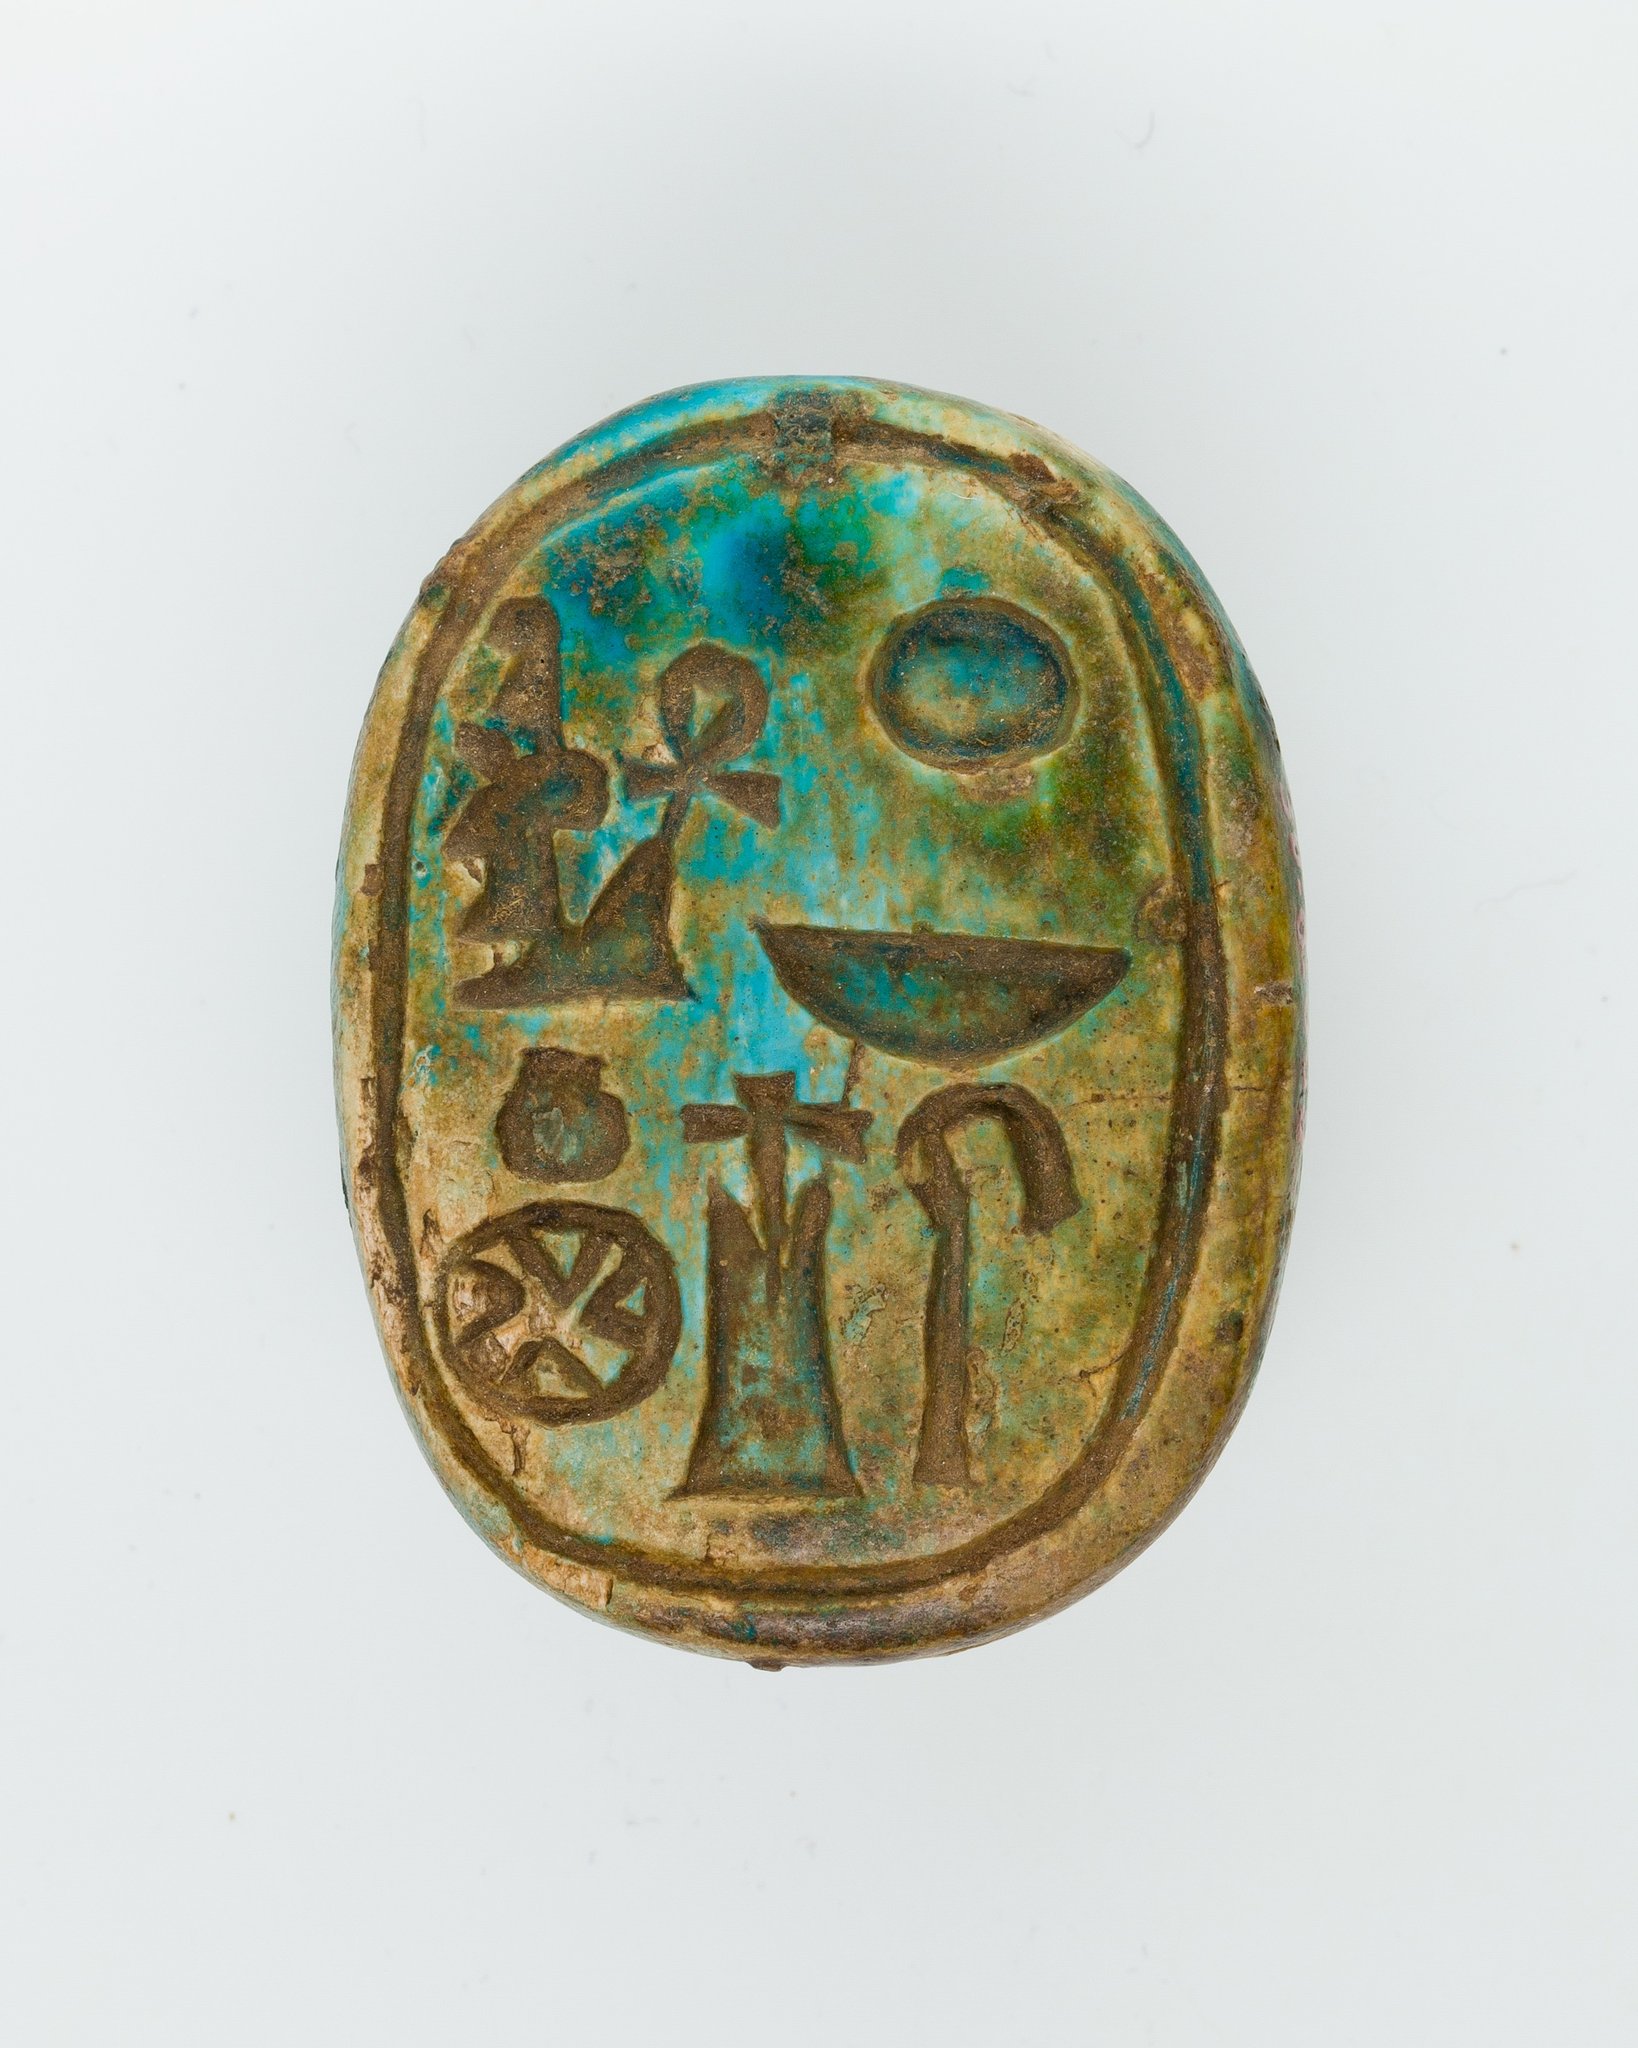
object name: scarab, amenhotep i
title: Scarab of Amenhotep III, ruler of Heliopolis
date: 1390-1352 BCE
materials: stone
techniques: glazing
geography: egypt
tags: hieroglyphs,scarabs